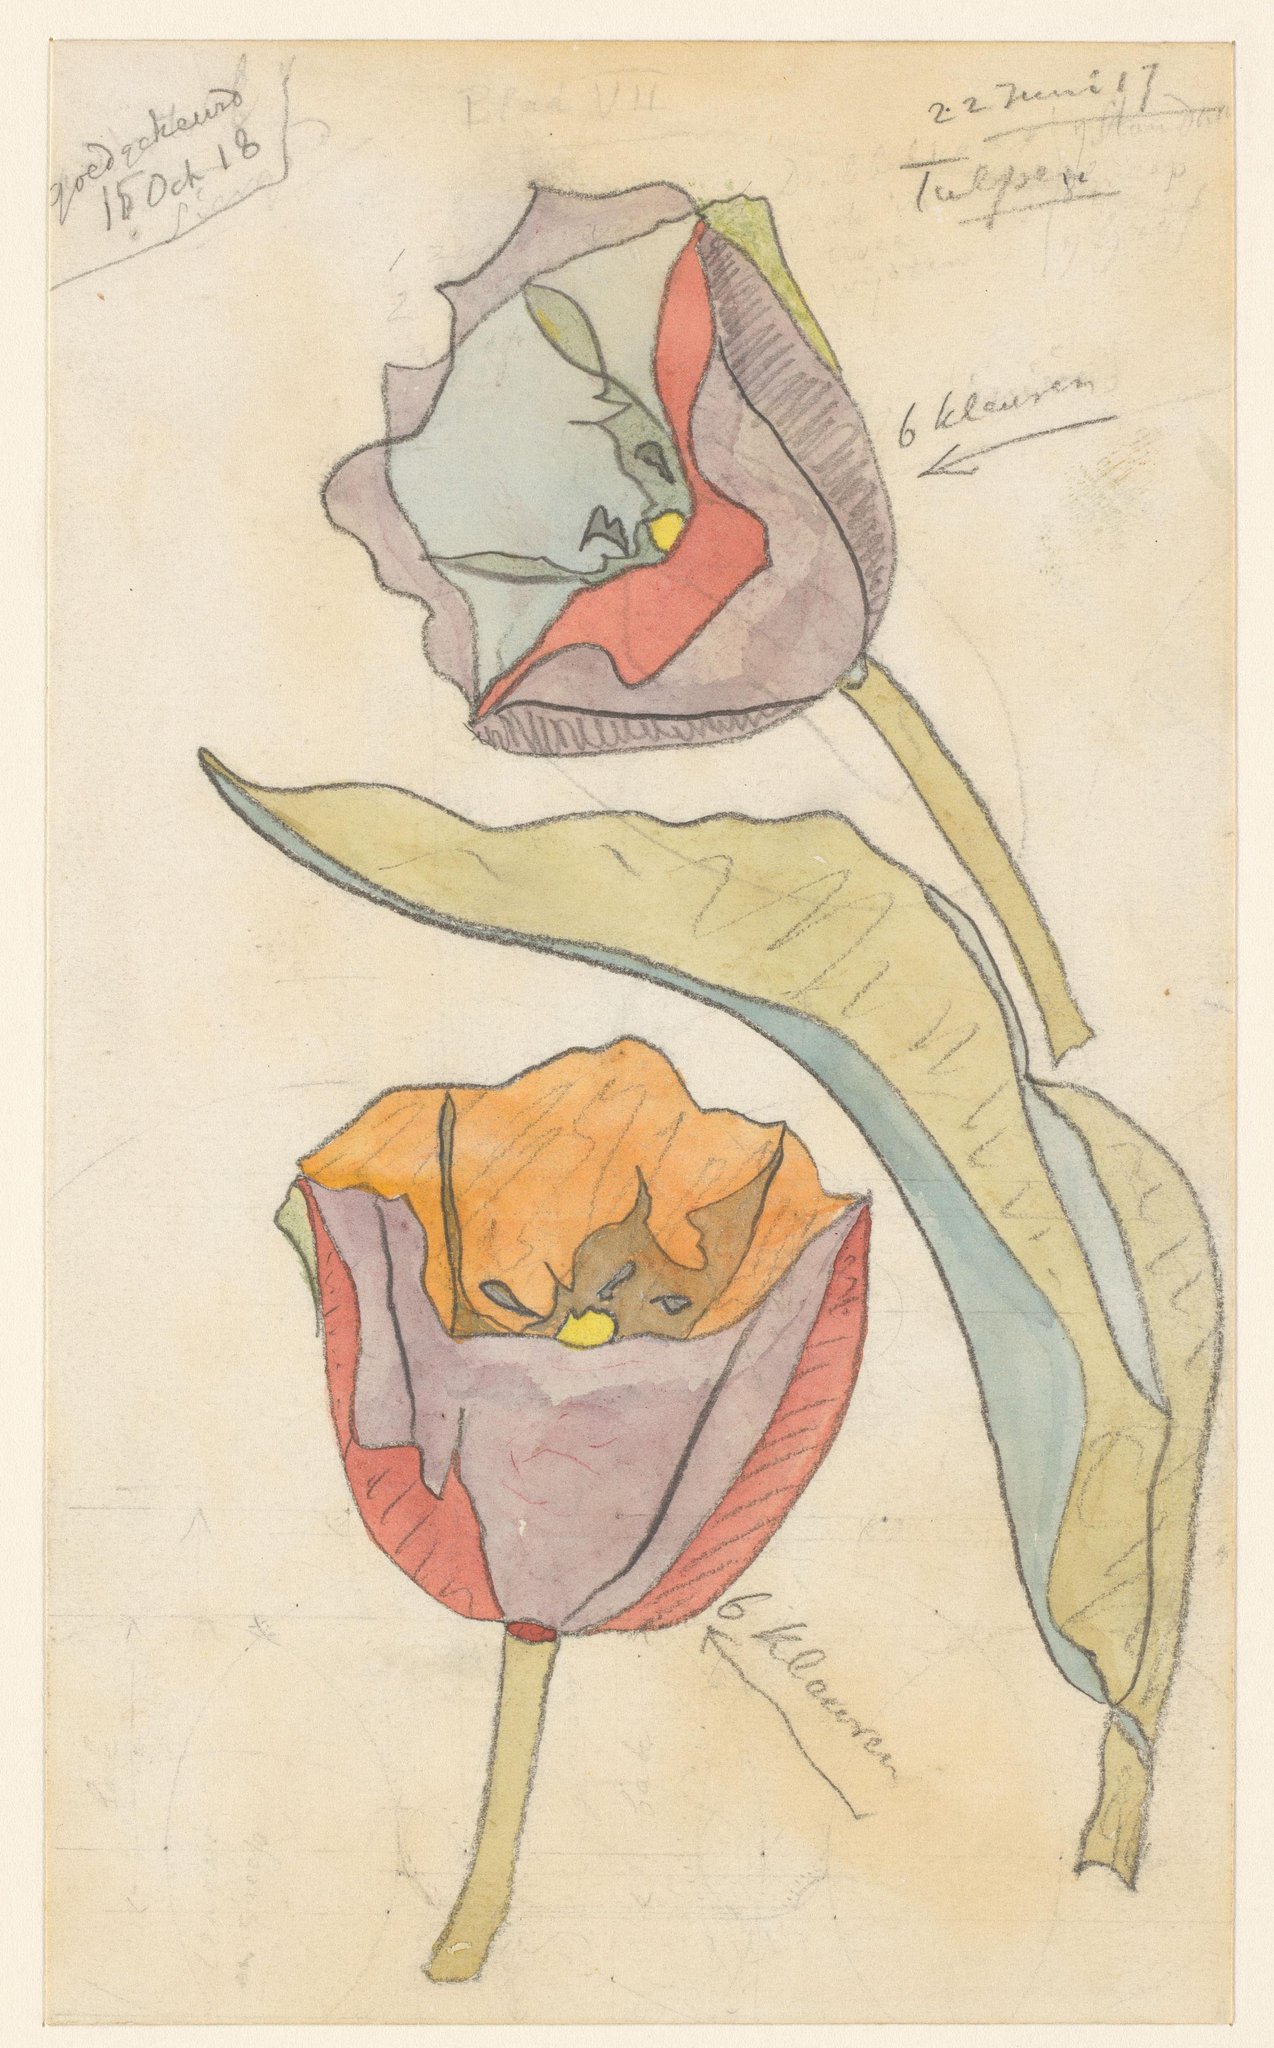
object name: design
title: Tulpen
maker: theo colenbrander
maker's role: draughtsman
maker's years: 1841-1930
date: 1917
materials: paper, pencil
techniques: brush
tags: flowers: tulip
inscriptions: date: ‘22 juni 17’